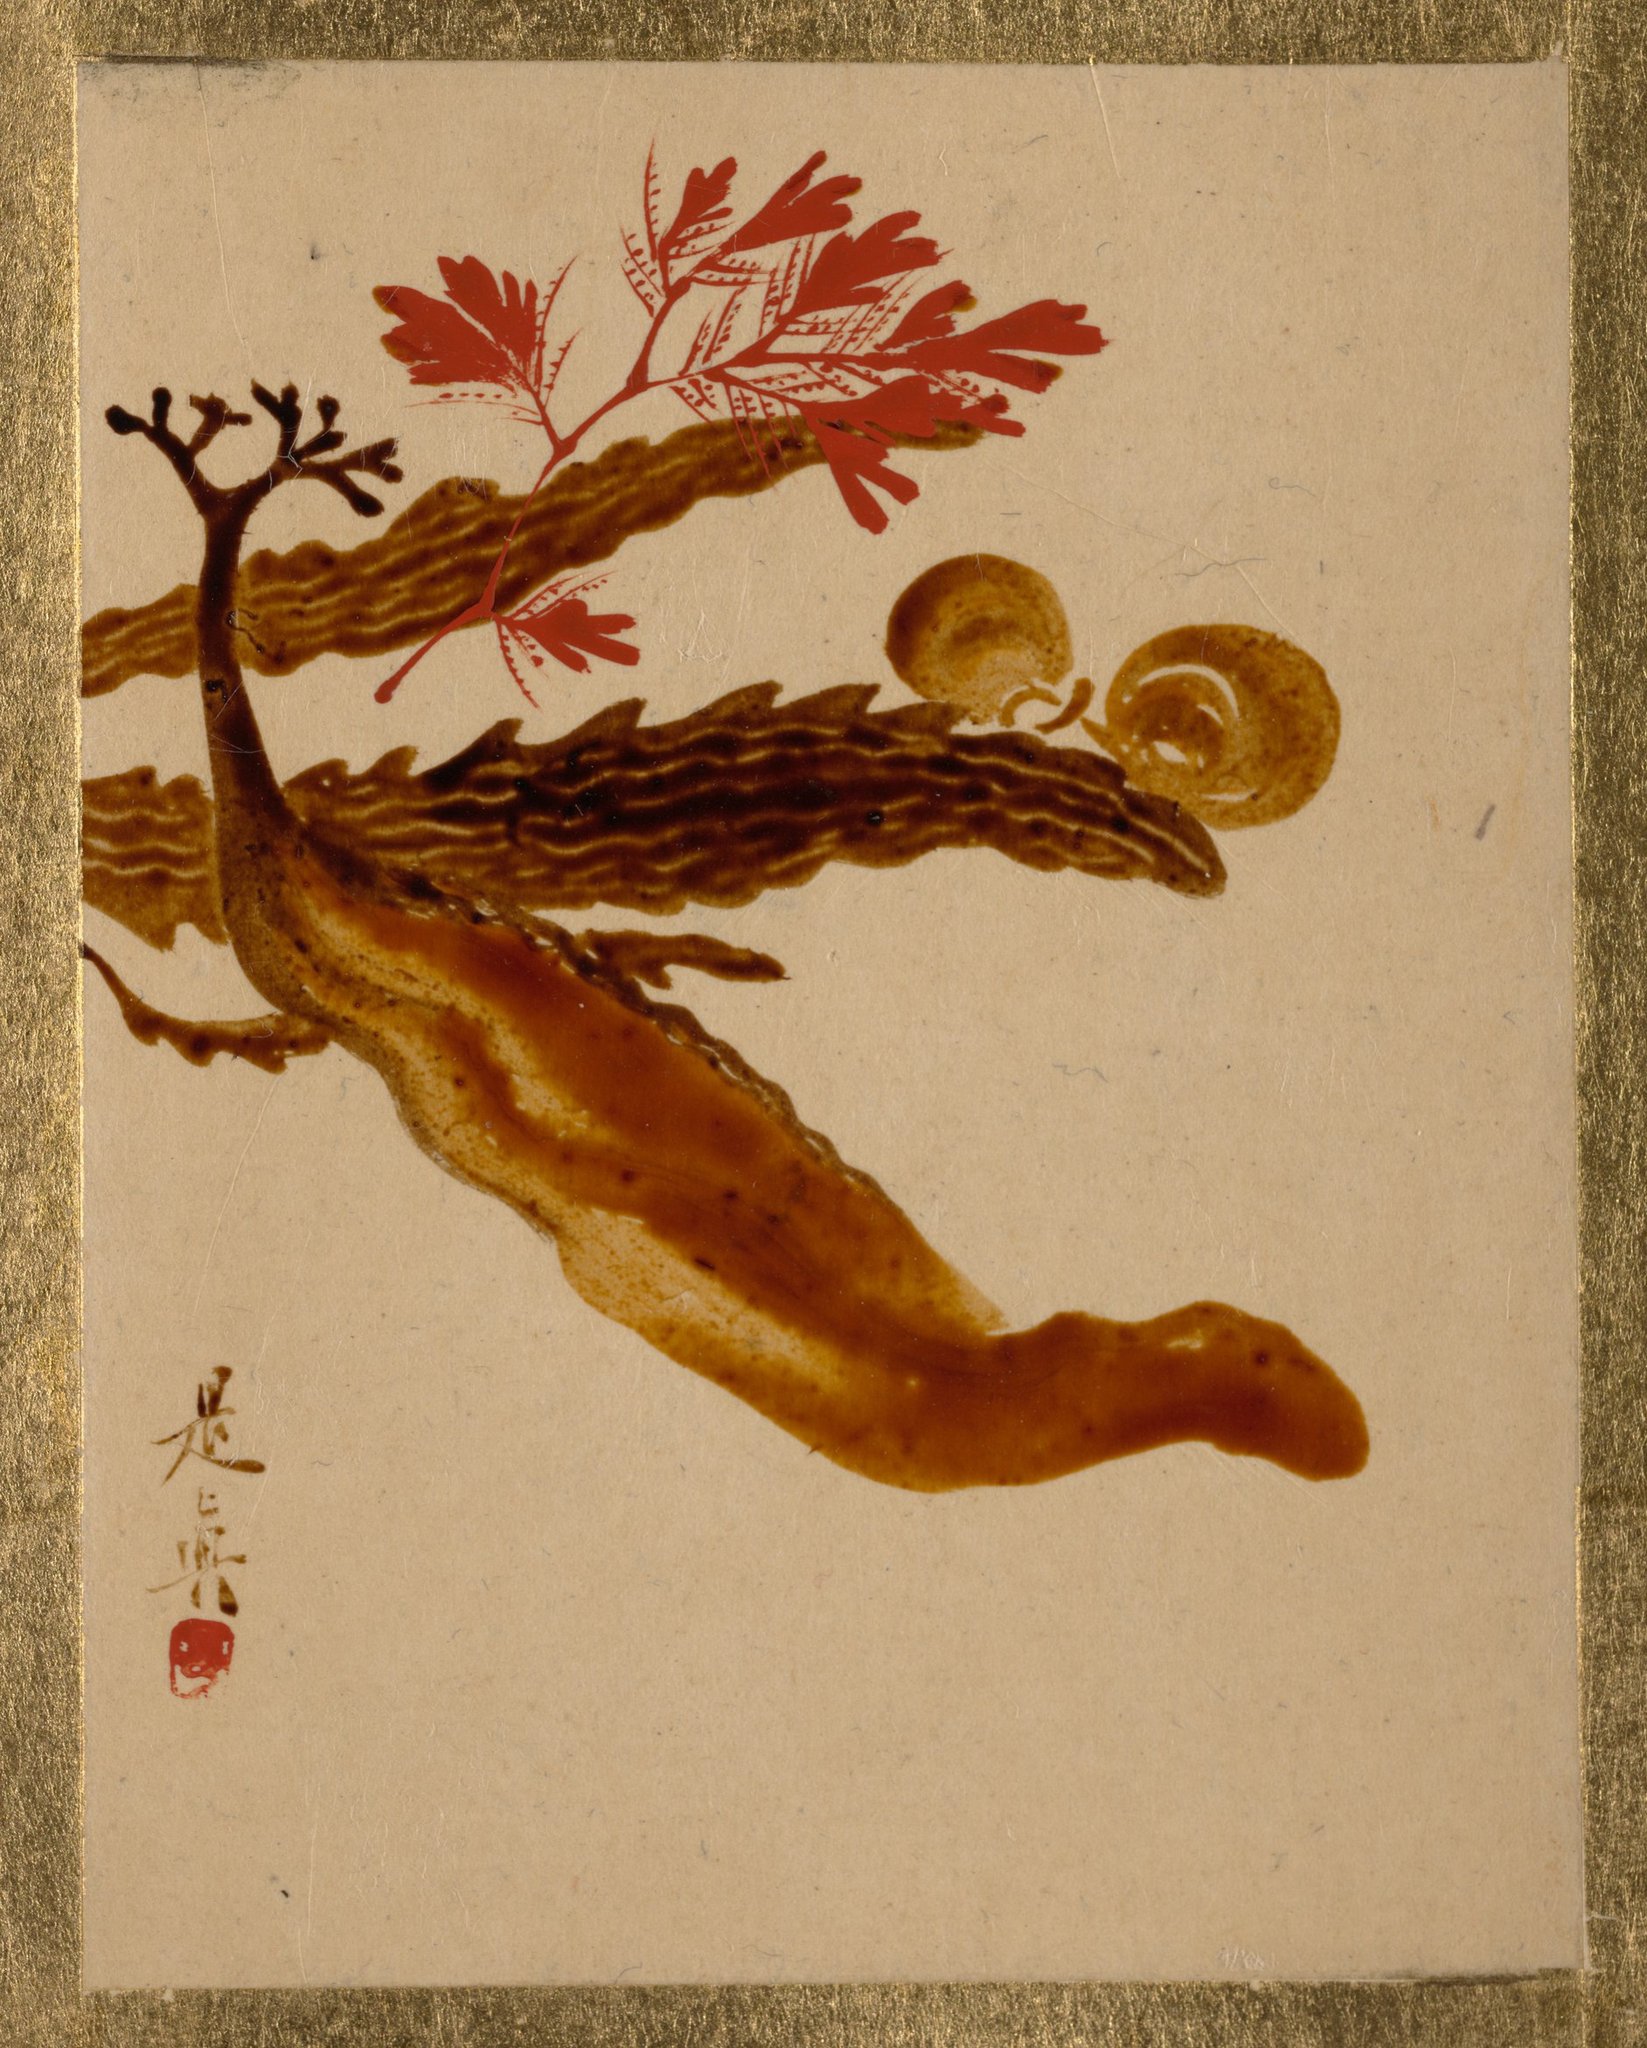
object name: album leaf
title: Seaweed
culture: japanese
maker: shibata zeshin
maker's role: artist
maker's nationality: japanese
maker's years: 1807-1891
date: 1807-1868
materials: lacquer, paper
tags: plants